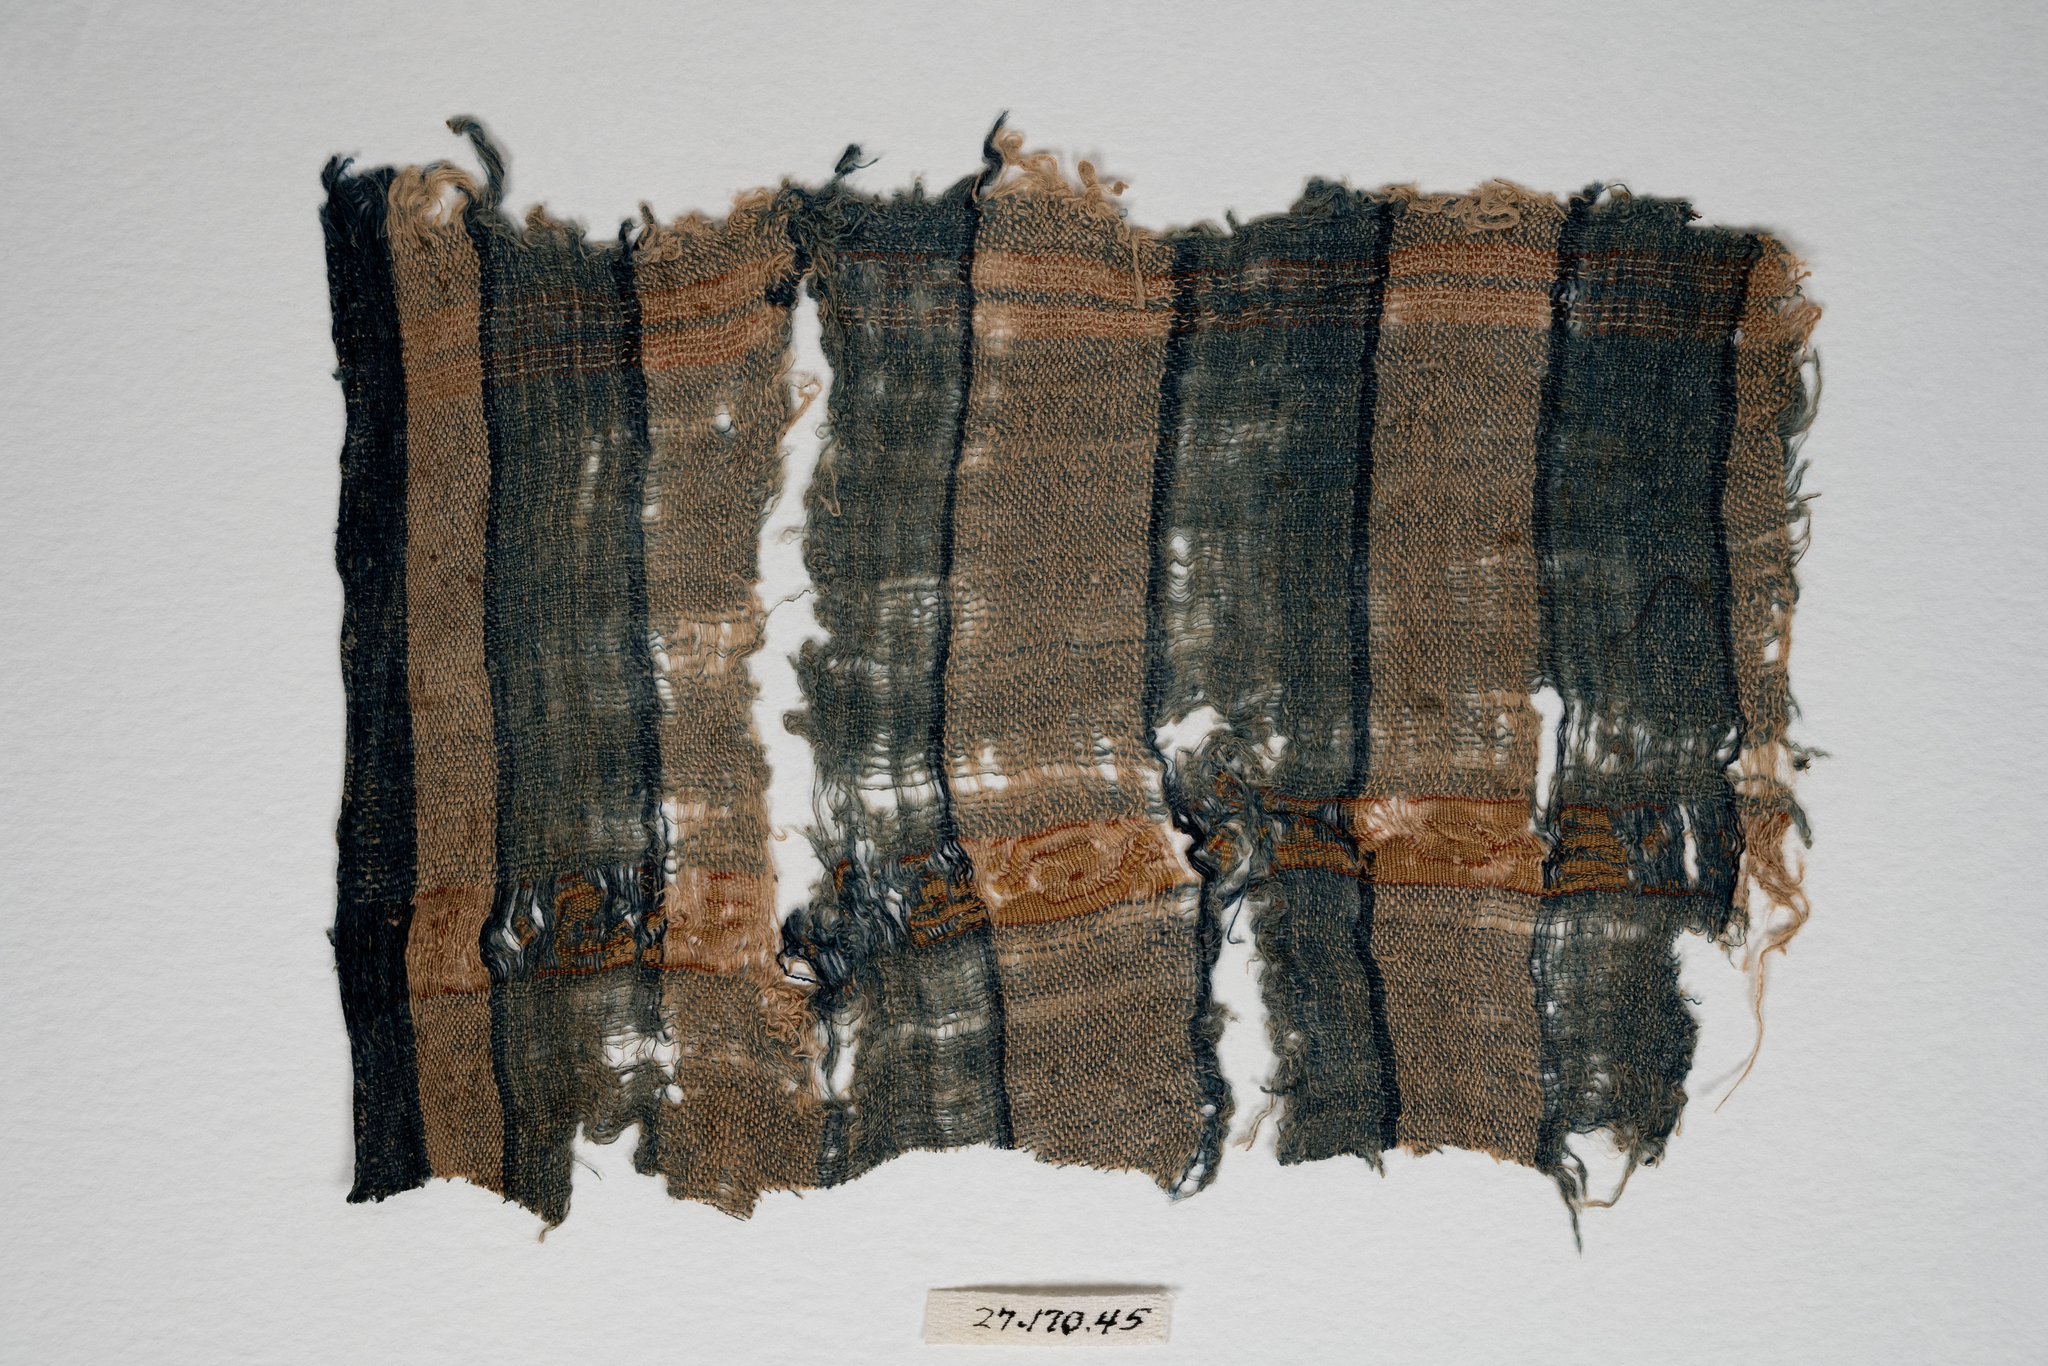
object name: textile fragment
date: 1101-1200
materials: linen, silk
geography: egypt